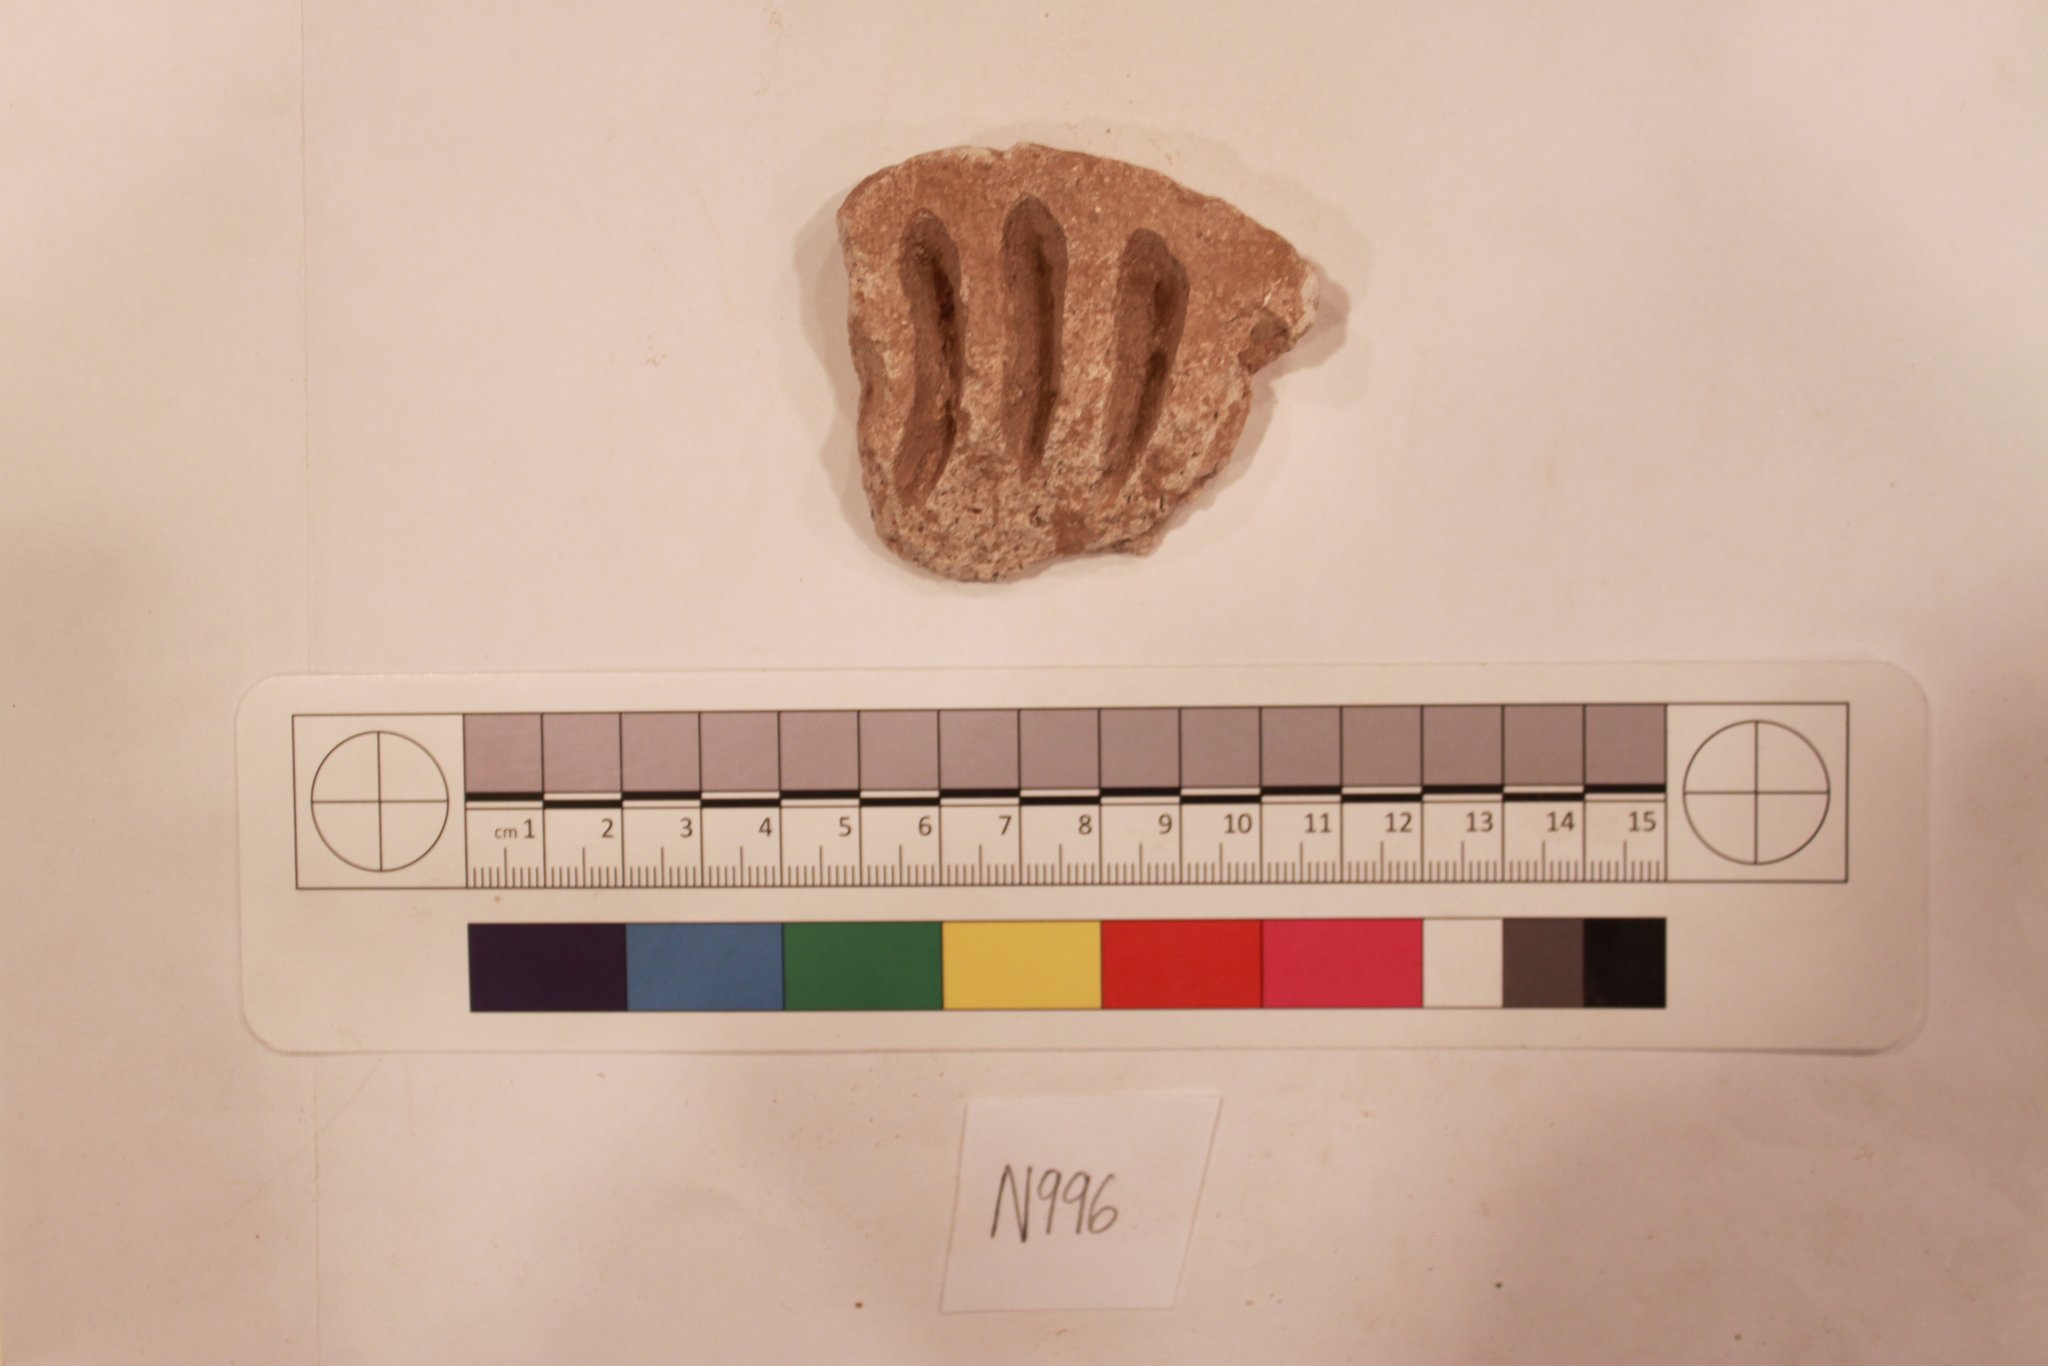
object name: fragment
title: Stucco Fragment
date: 701-1200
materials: plaster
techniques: carving, painting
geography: iran